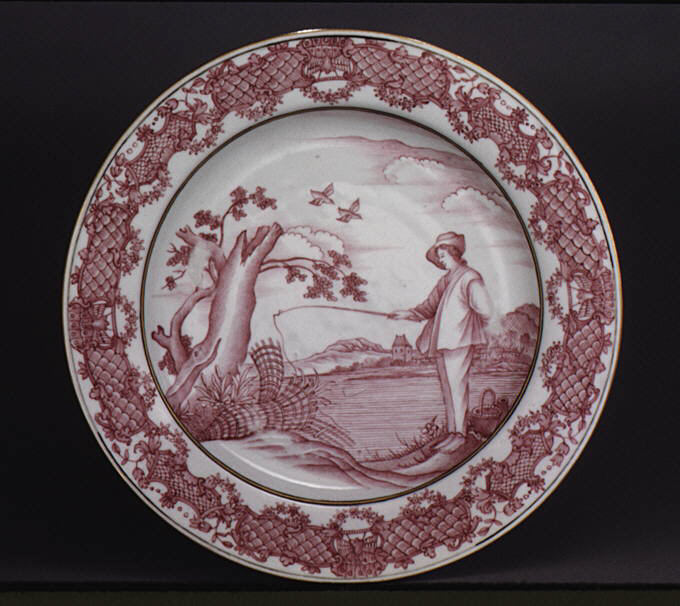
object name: plate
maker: abraham bloemaert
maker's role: artist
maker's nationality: netherlandish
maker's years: 1566-1651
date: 1750-1760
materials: hard paste porcelain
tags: birds,men,fishing,trees